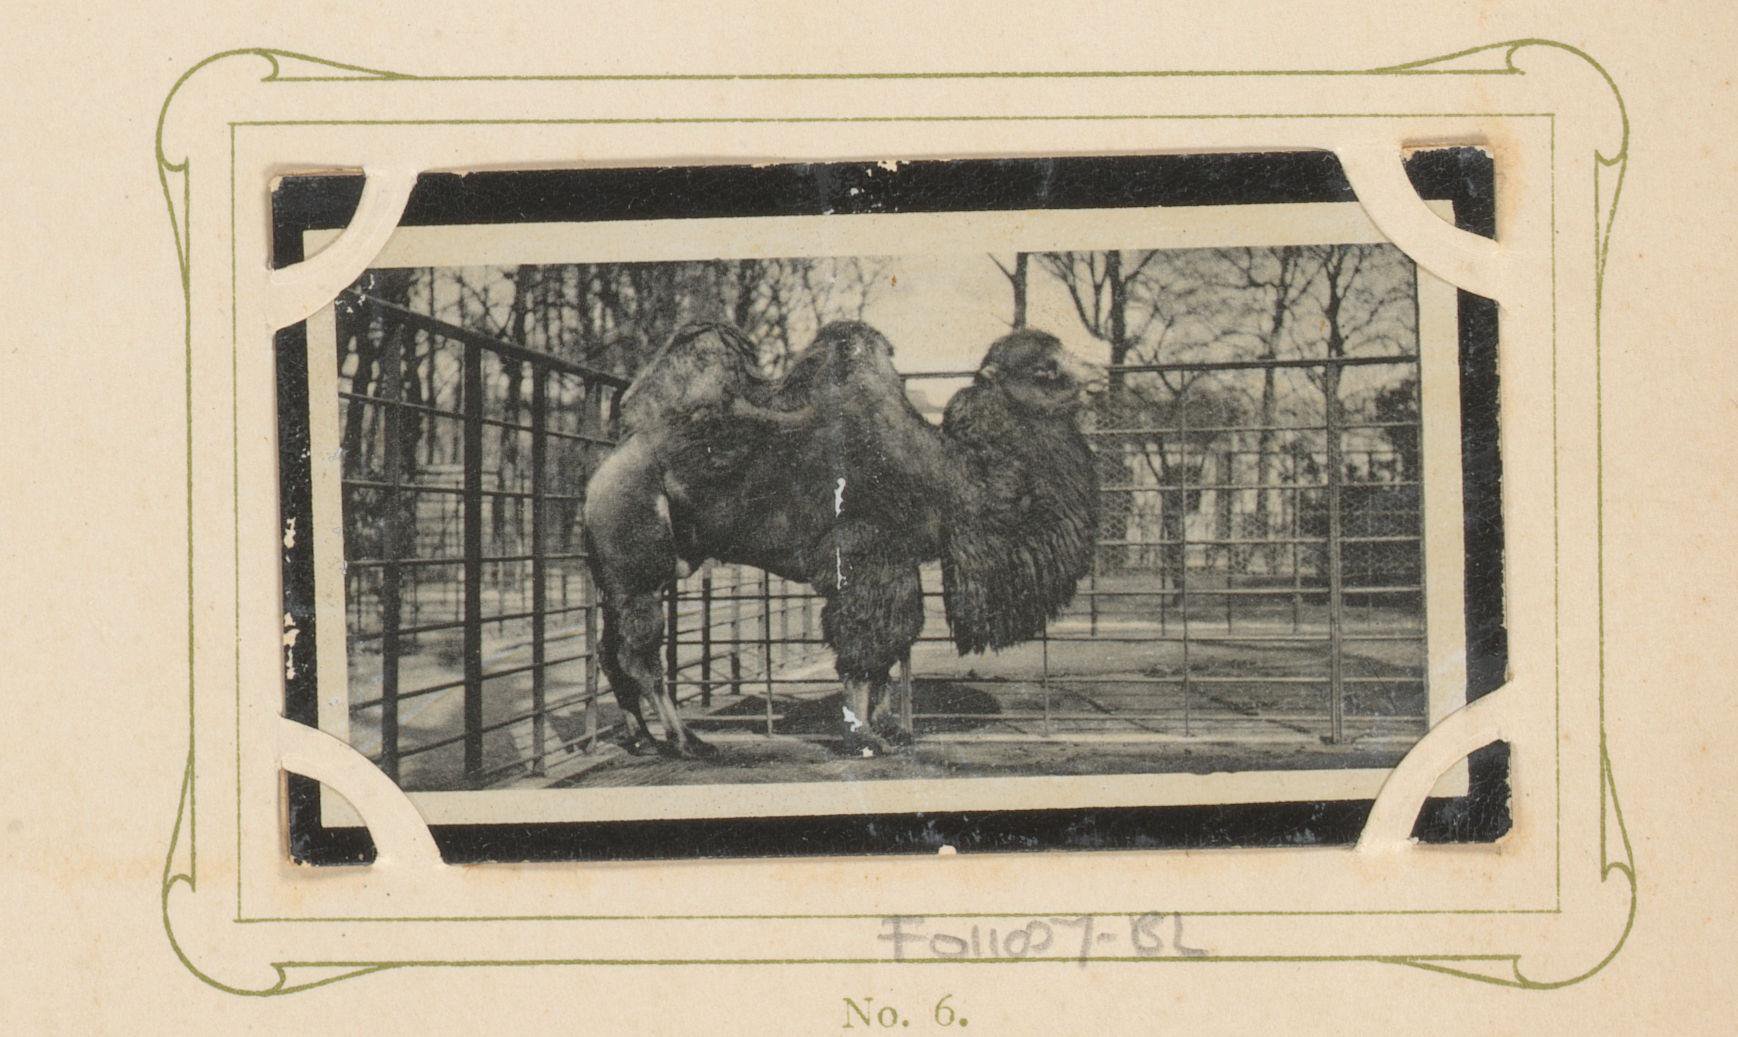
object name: album leaf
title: Kameel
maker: Anonymous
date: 1905-1906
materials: paper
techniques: photograph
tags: hoofed animals: camel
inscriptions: inscription: ‘No. 6./ Drommedaris.’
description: Deze prent maakt deel uit van een album.